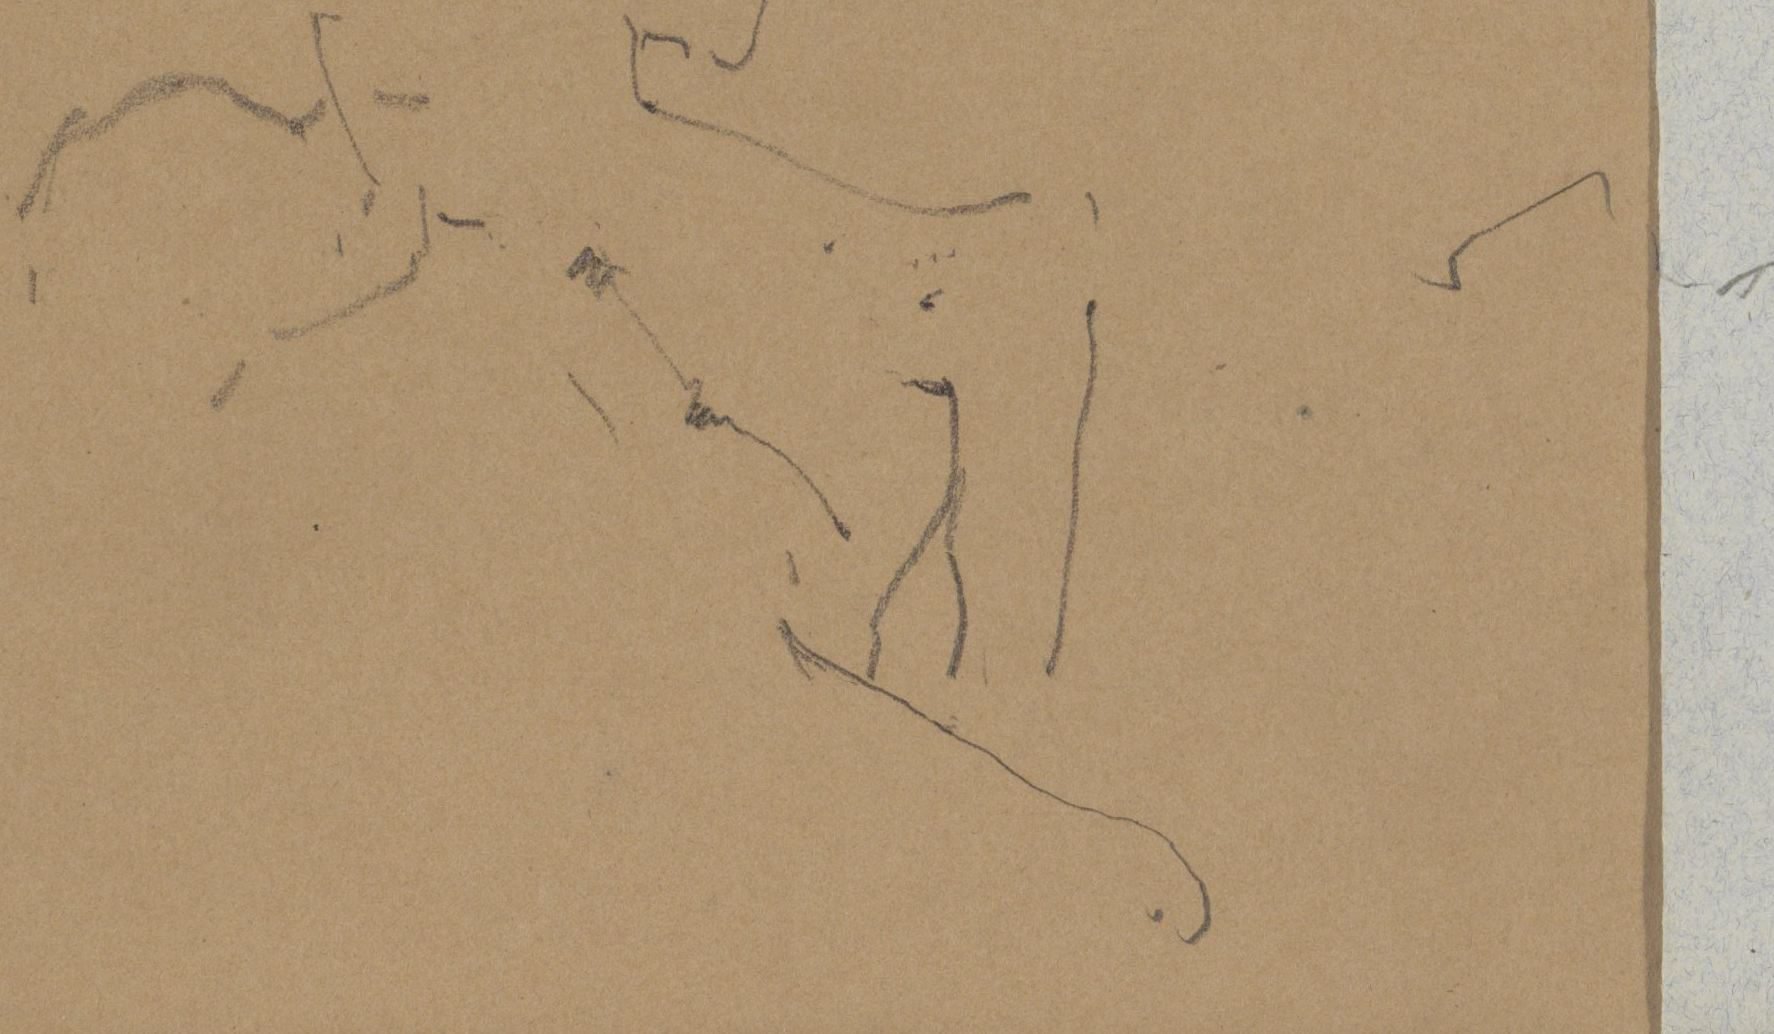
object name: sketchbook leaf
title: Studie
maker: george hendrik breitner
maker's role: draughtsman, painter, print maker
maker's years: 1857-1923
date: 1880-1882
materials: paper, pencil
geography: the hague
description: Blad 29 verso uit een schetsboek met 16 bladen.